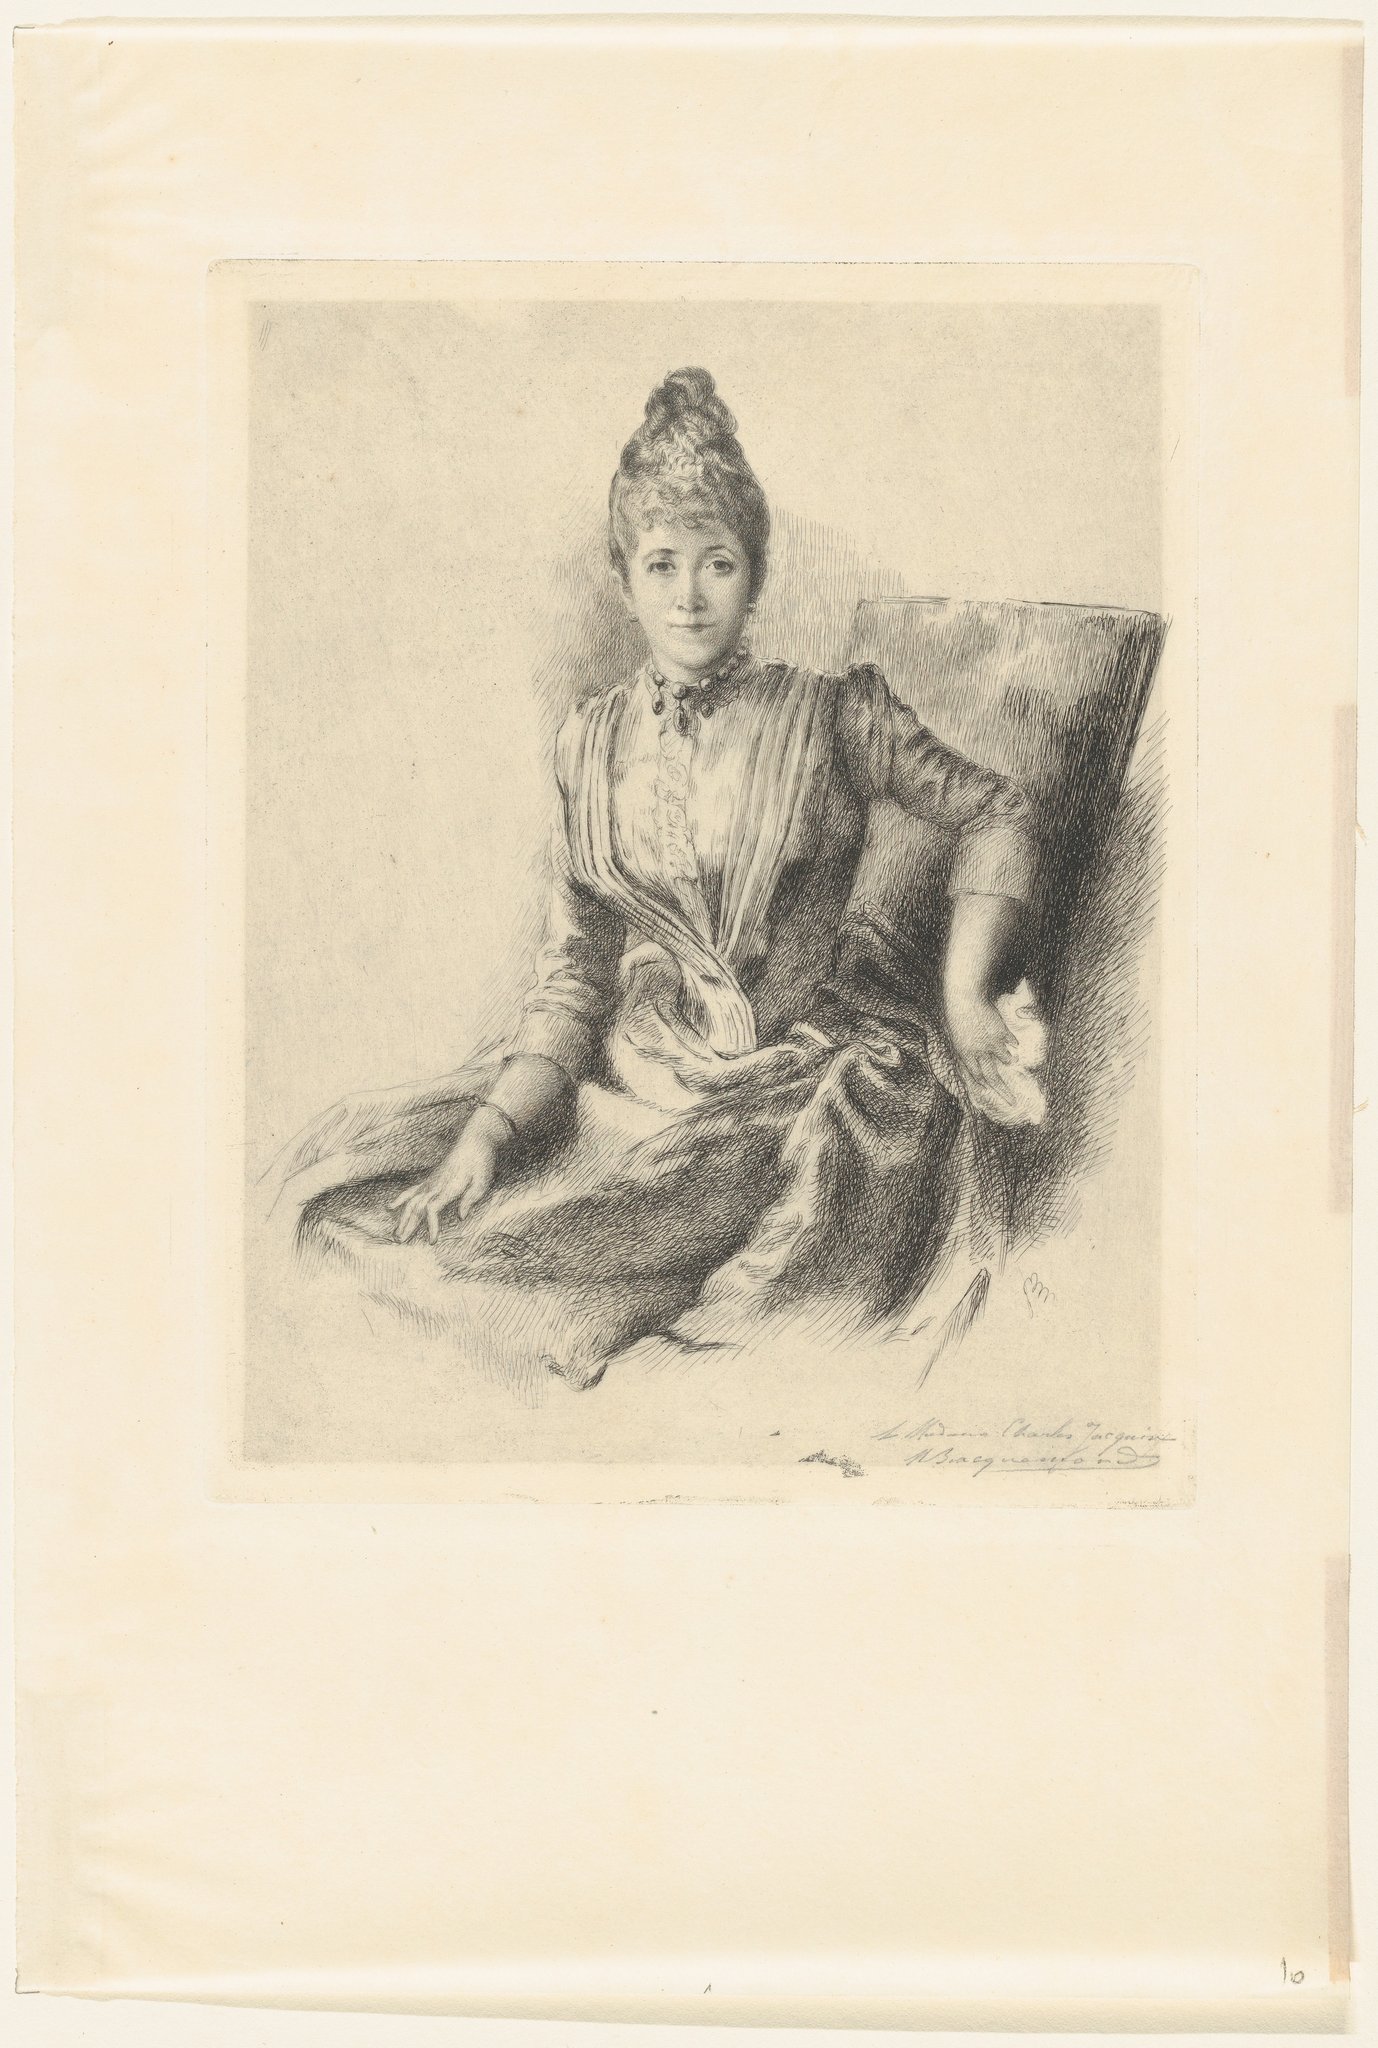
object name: print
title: Portrait of Mlle Quivoron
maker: marie bracquemond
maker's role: artist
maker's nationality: french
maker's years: 1841-1916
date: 1860-1914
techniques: drypoint, etching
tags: portraits,women